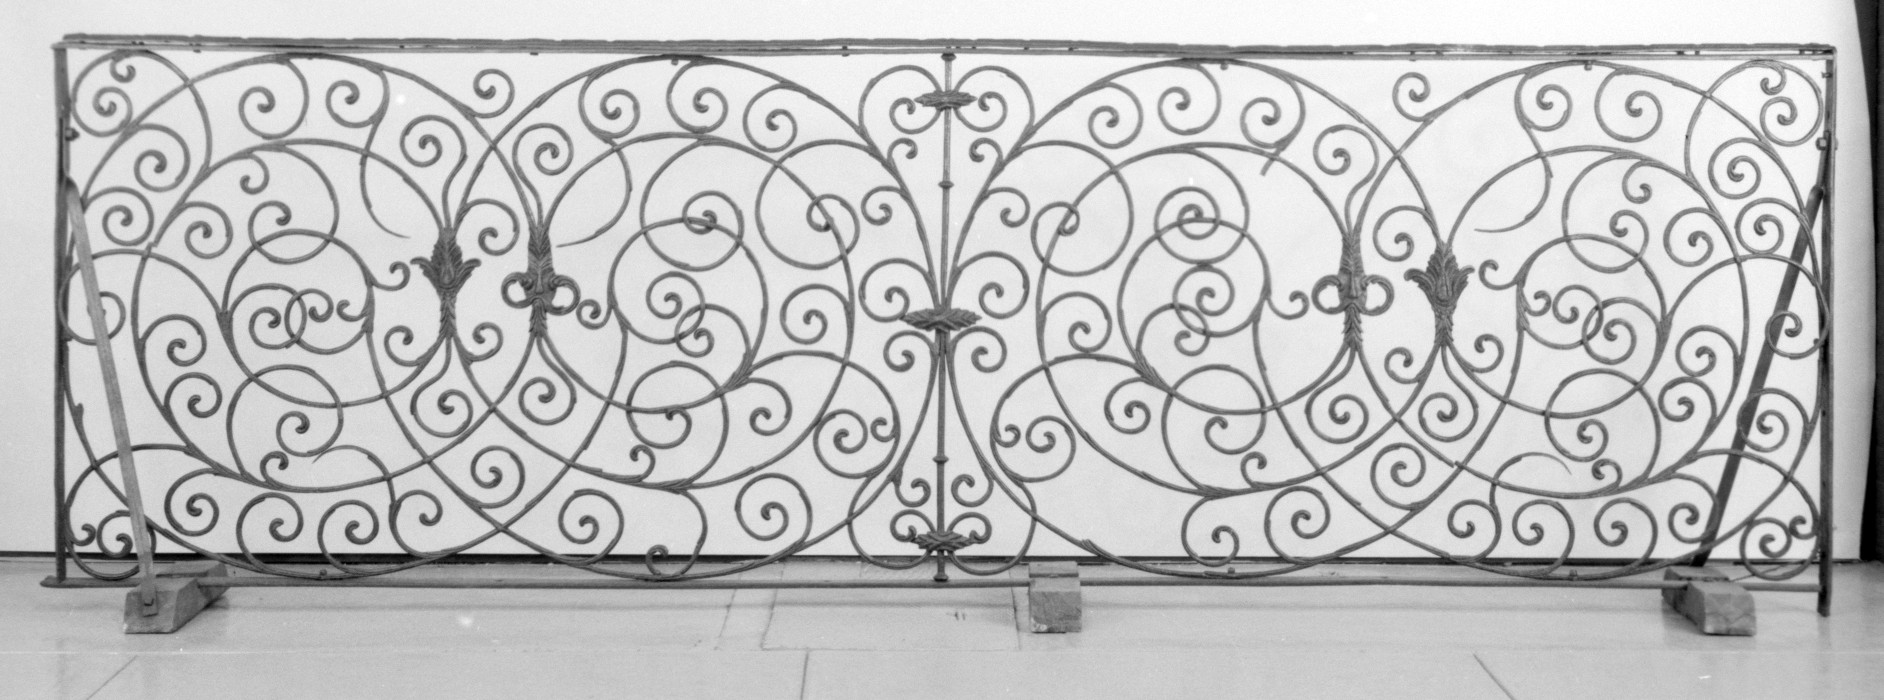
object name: grill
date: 1651-1700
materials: iron